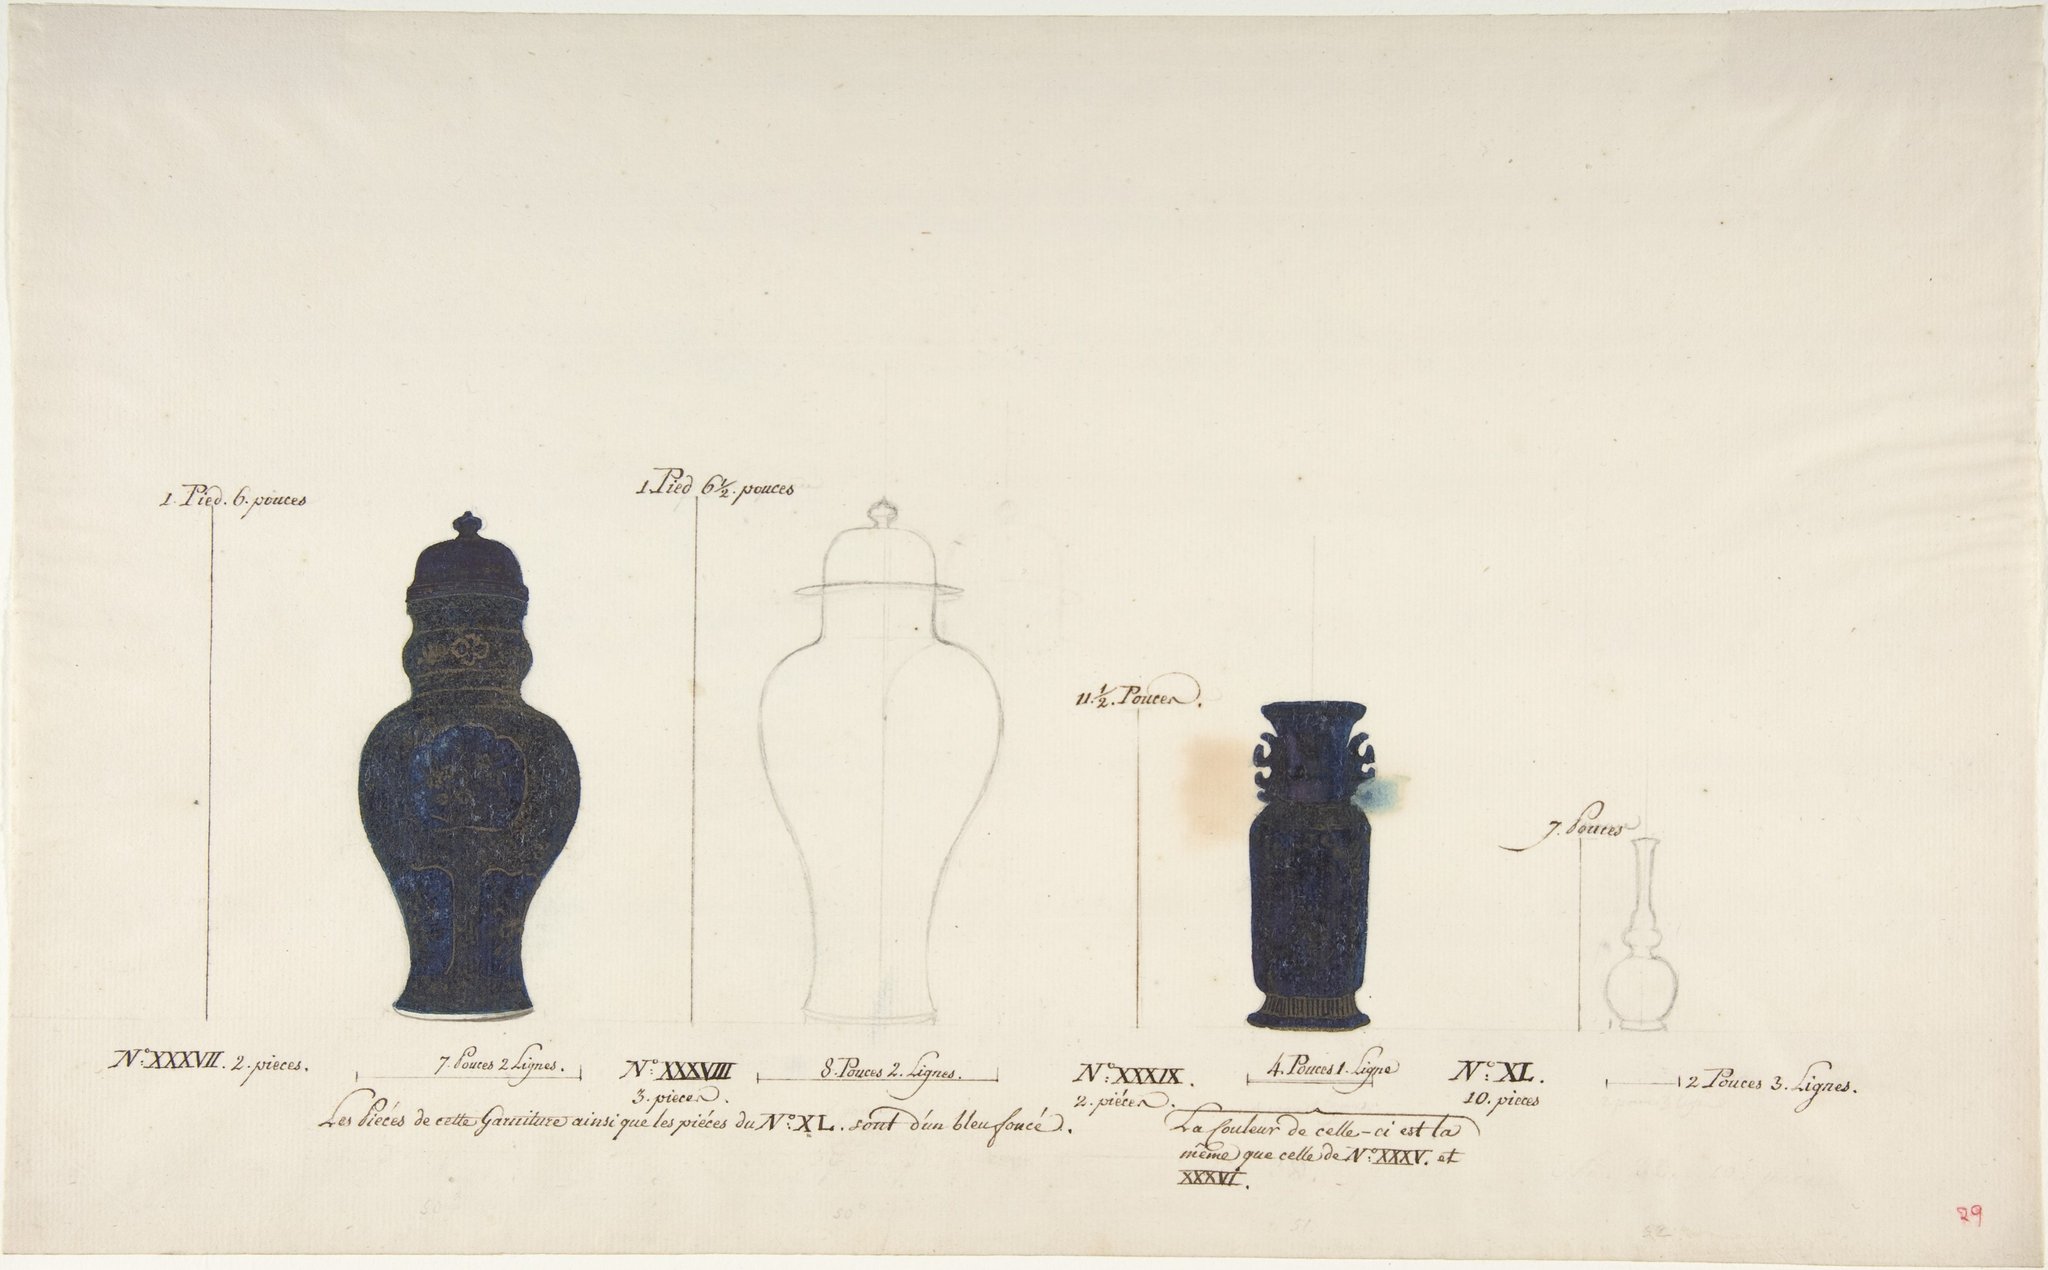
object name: drawing ornament architecture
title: Design for Four Vases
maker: anonymous, french, 18th century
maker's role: artist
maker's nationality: french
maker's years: 1700-1800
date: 1770-1785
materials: chalk, ink, watercolor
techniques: pen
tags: vases